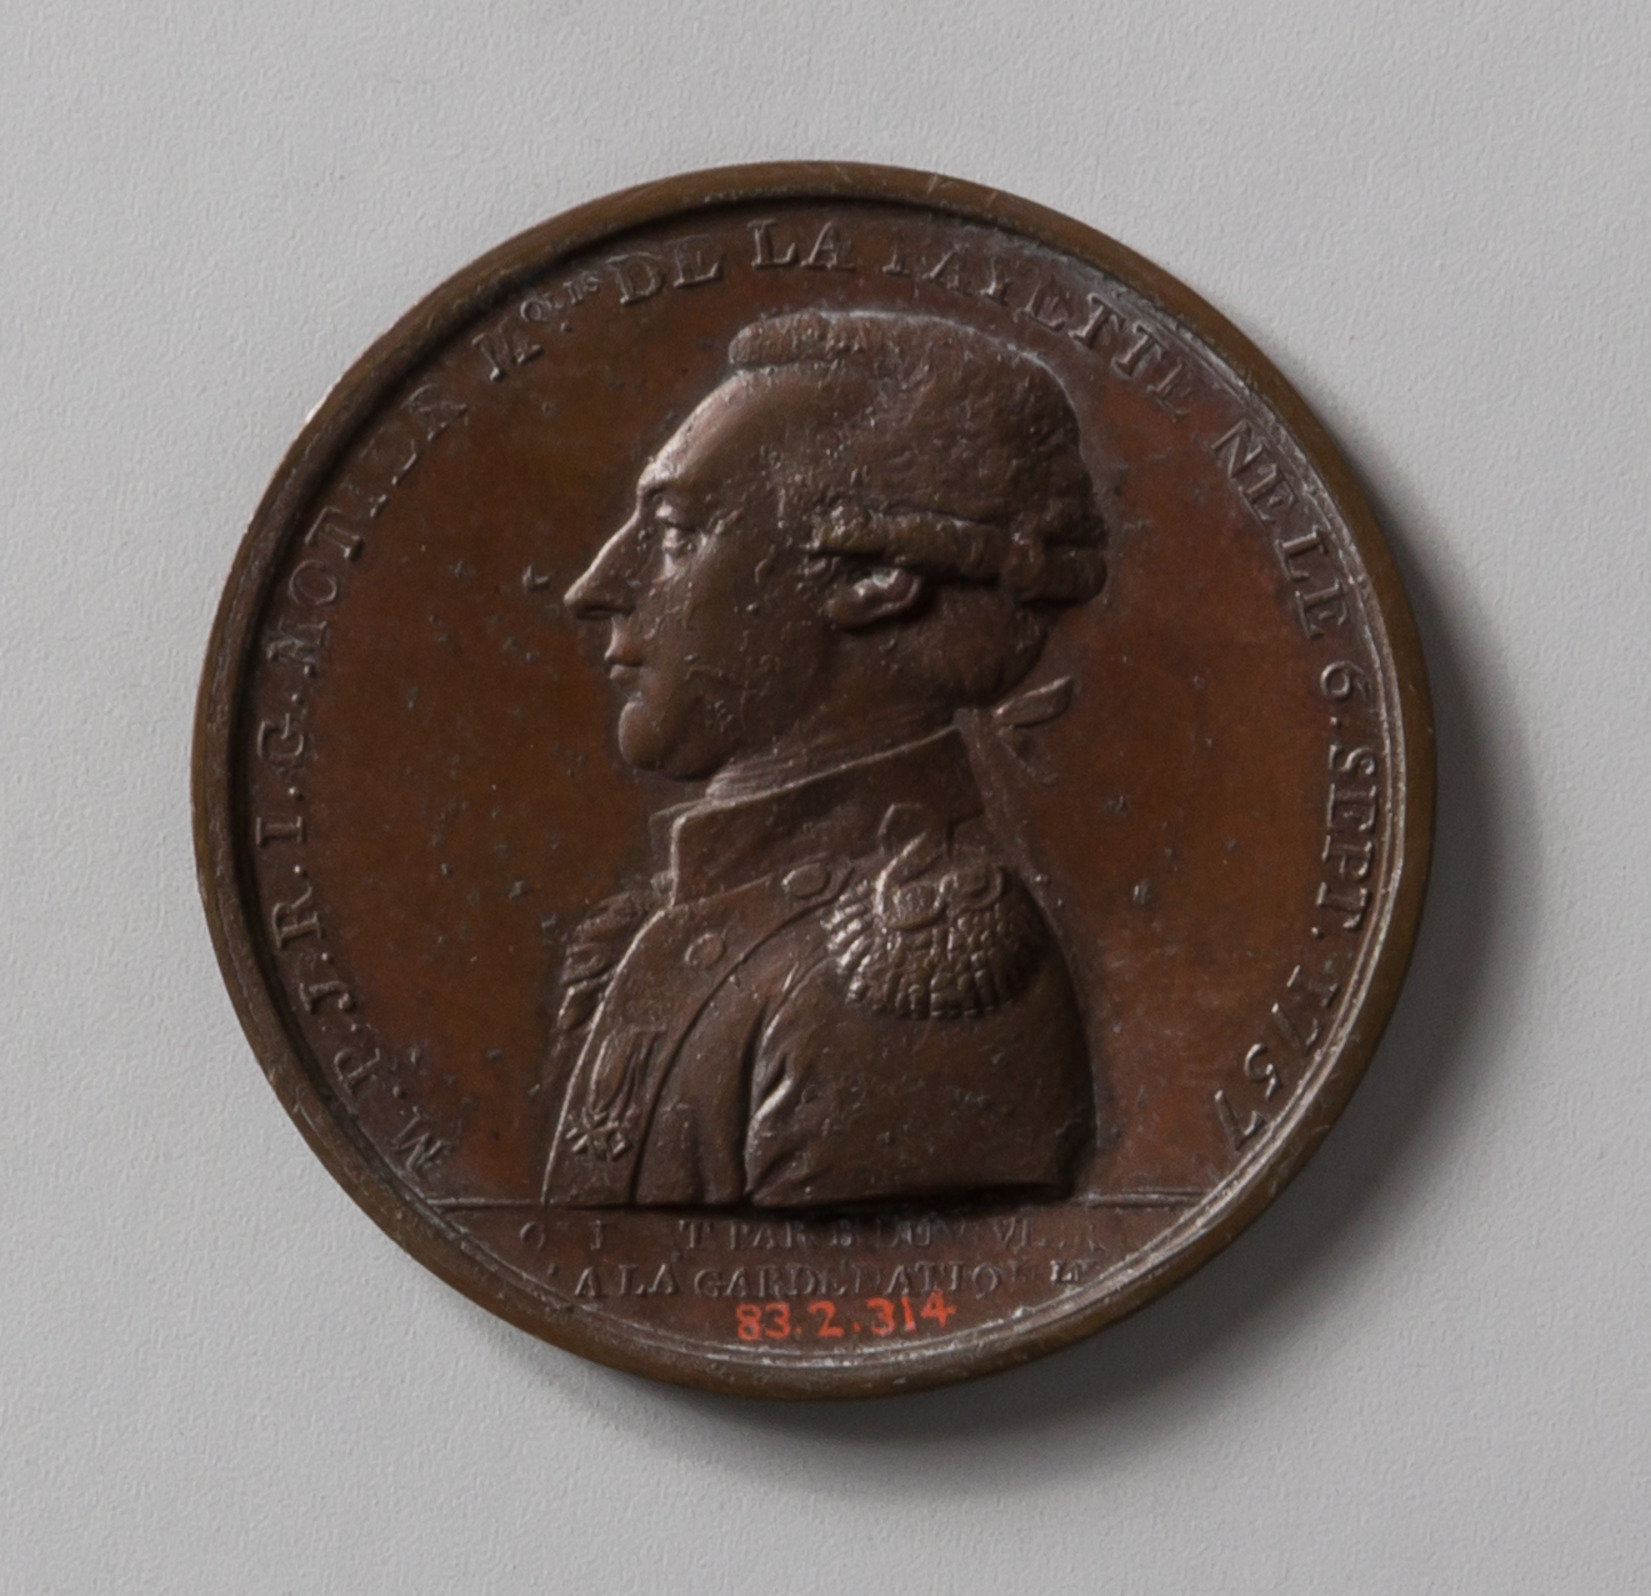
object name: medal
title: Medal of the Marquis de Lafayette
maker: pierre simon benj. duvivier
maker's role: maker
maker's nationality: french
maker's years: 1730-1819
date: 1789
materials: bronze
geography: france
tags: men,profiles,marquis de lafayette